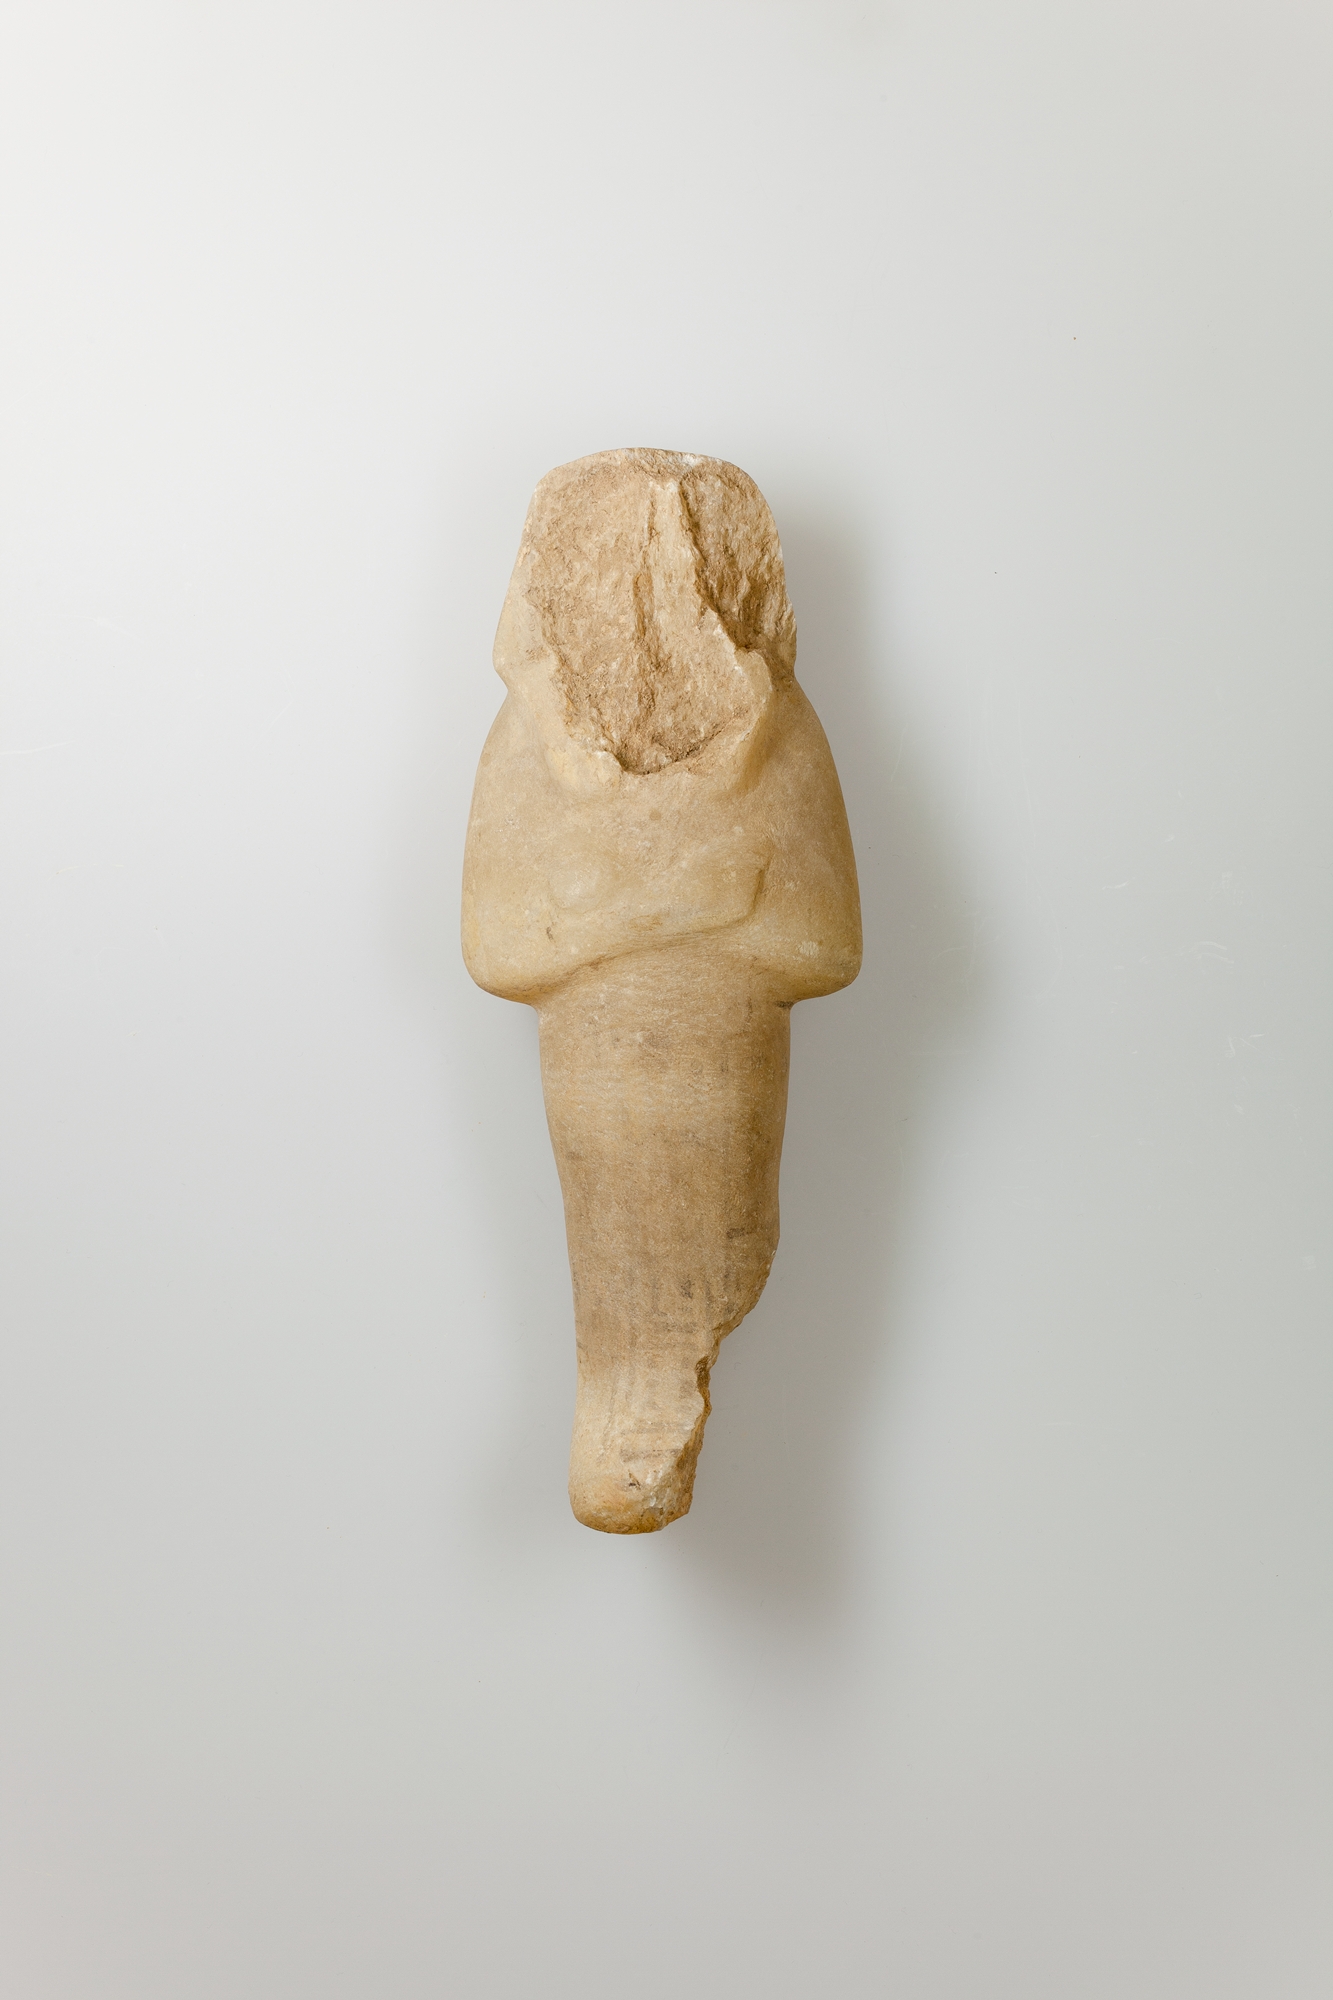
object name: shabti, siptah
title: Shabti of Siptah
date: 1194-1188 BCE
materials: stone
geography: egypt